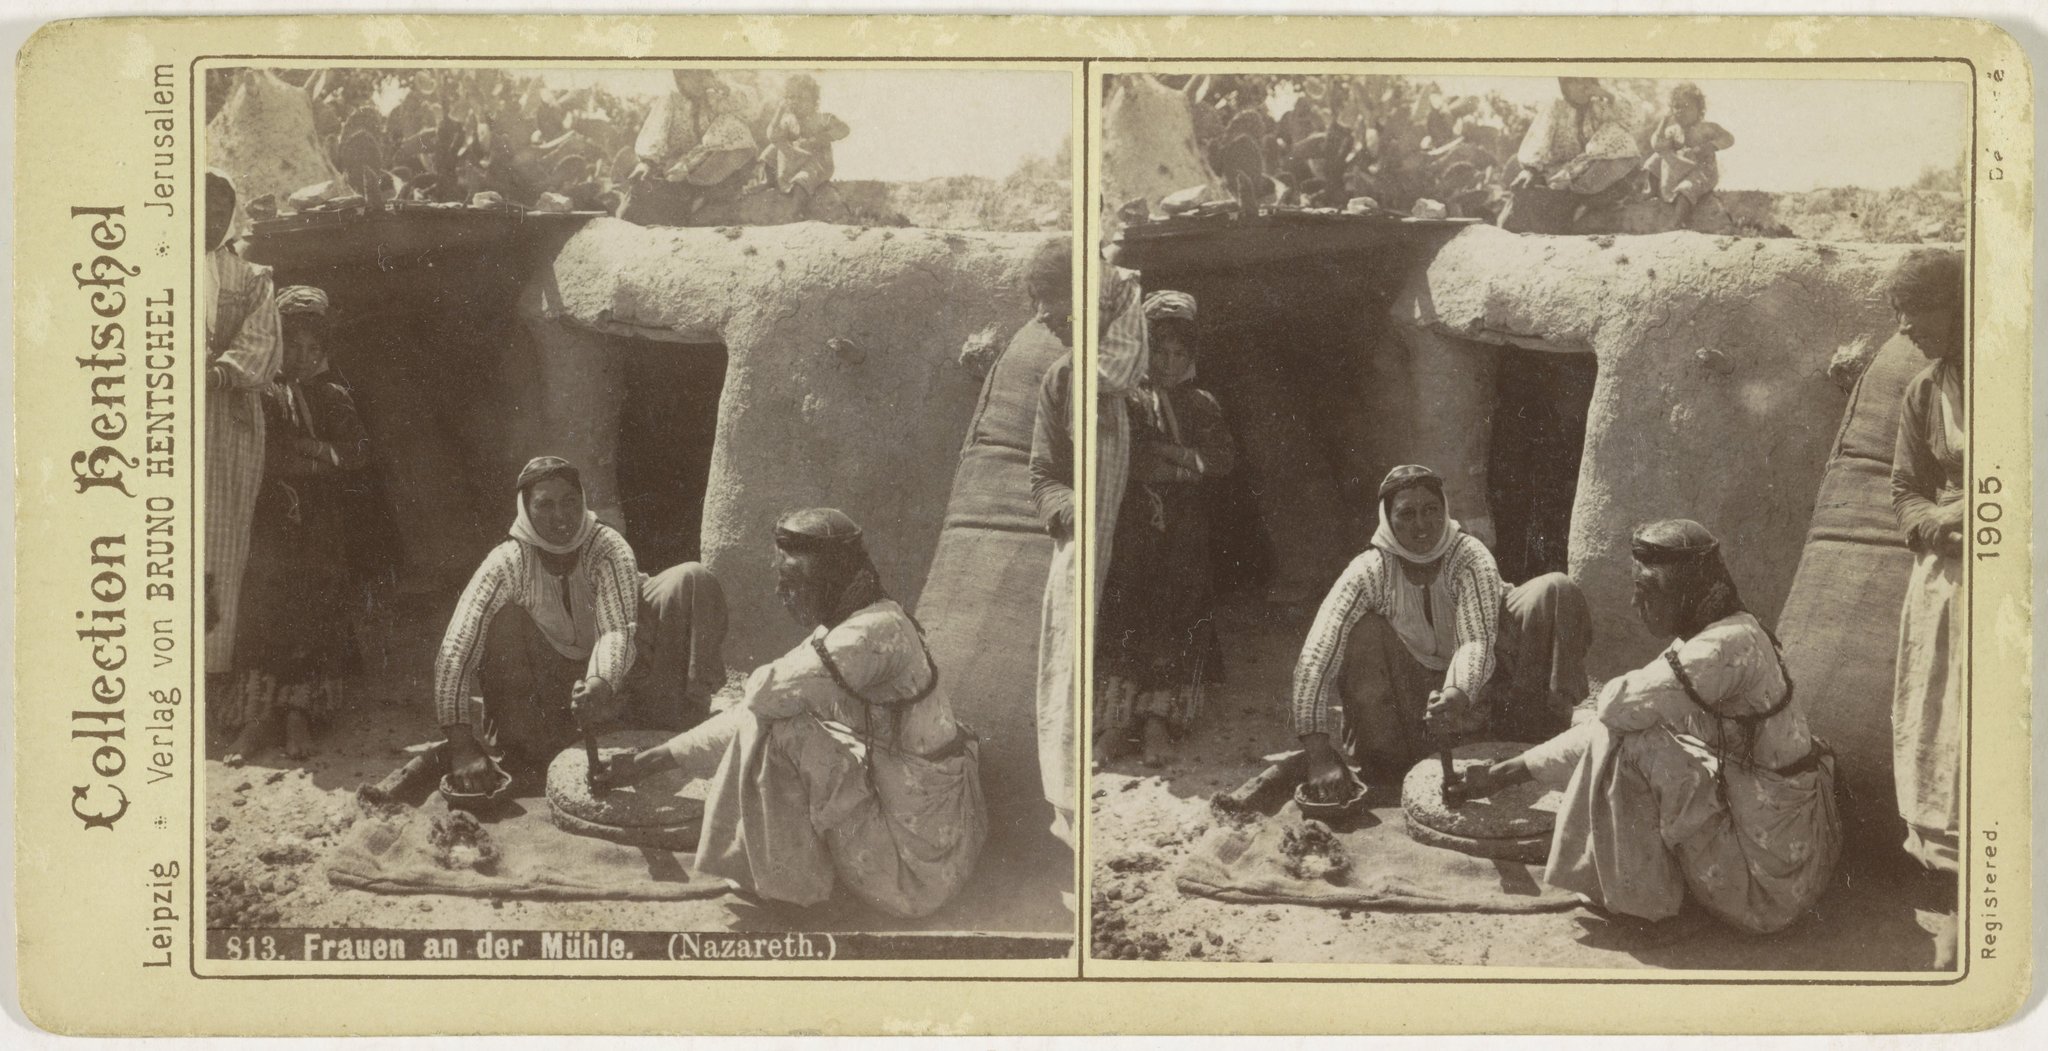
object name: stereograph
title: Frauen an der Mühle. (Nazareth)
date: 1905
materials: cardboard, paper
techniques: albumen print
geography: leipzig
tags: handicrafts ~ other plant material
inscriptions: inscription: ‘Registered.’, number: ‘813.’, inscription: ‘Déposé.’